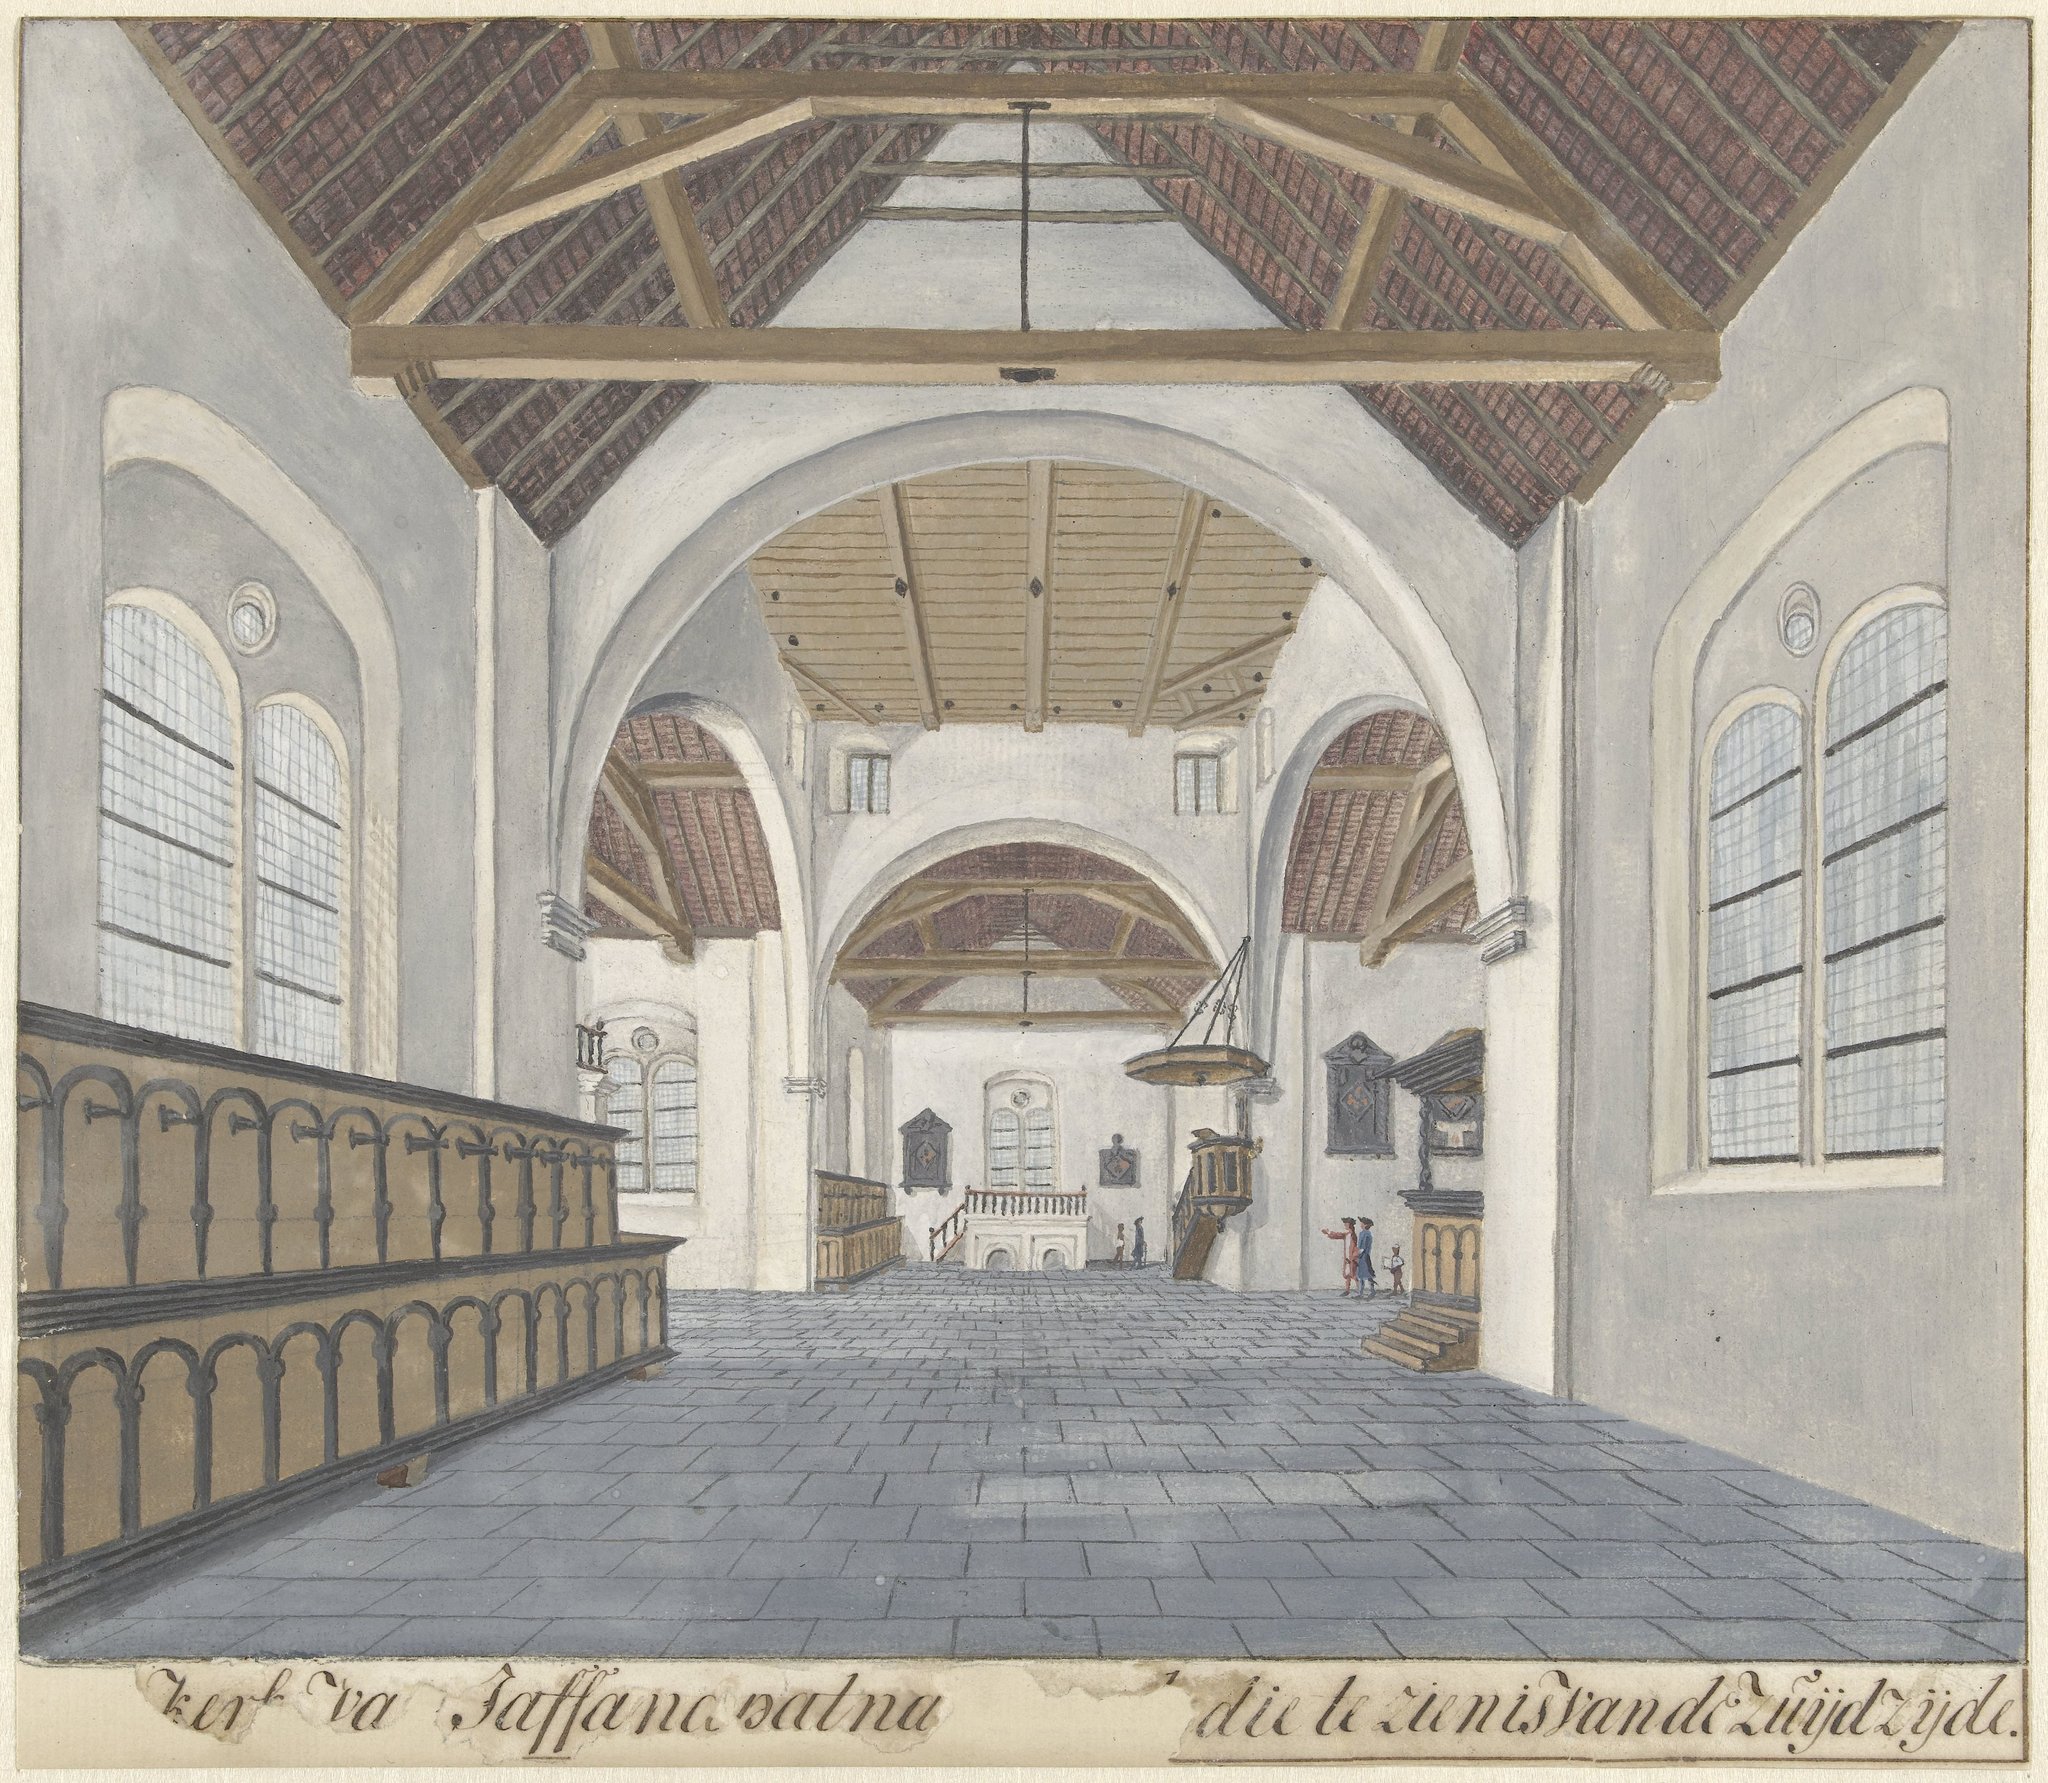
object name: drawing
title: Interior of the Church at Fort Jaffnapatnam in Jaffna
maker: cornelis steiger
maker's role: draughtsman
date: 1710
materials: paint, paper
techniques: brush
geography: sri lanka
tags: interior of church, sri lanka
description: The forts captured from the Portuguese were taken over and fortified by the VOC. These forts constituted a crucial chain that extended along the entire coast of the island. While their primary purpose was to deter European competitors, they were also used to restrict the king of Kandy’s freedom of movement.